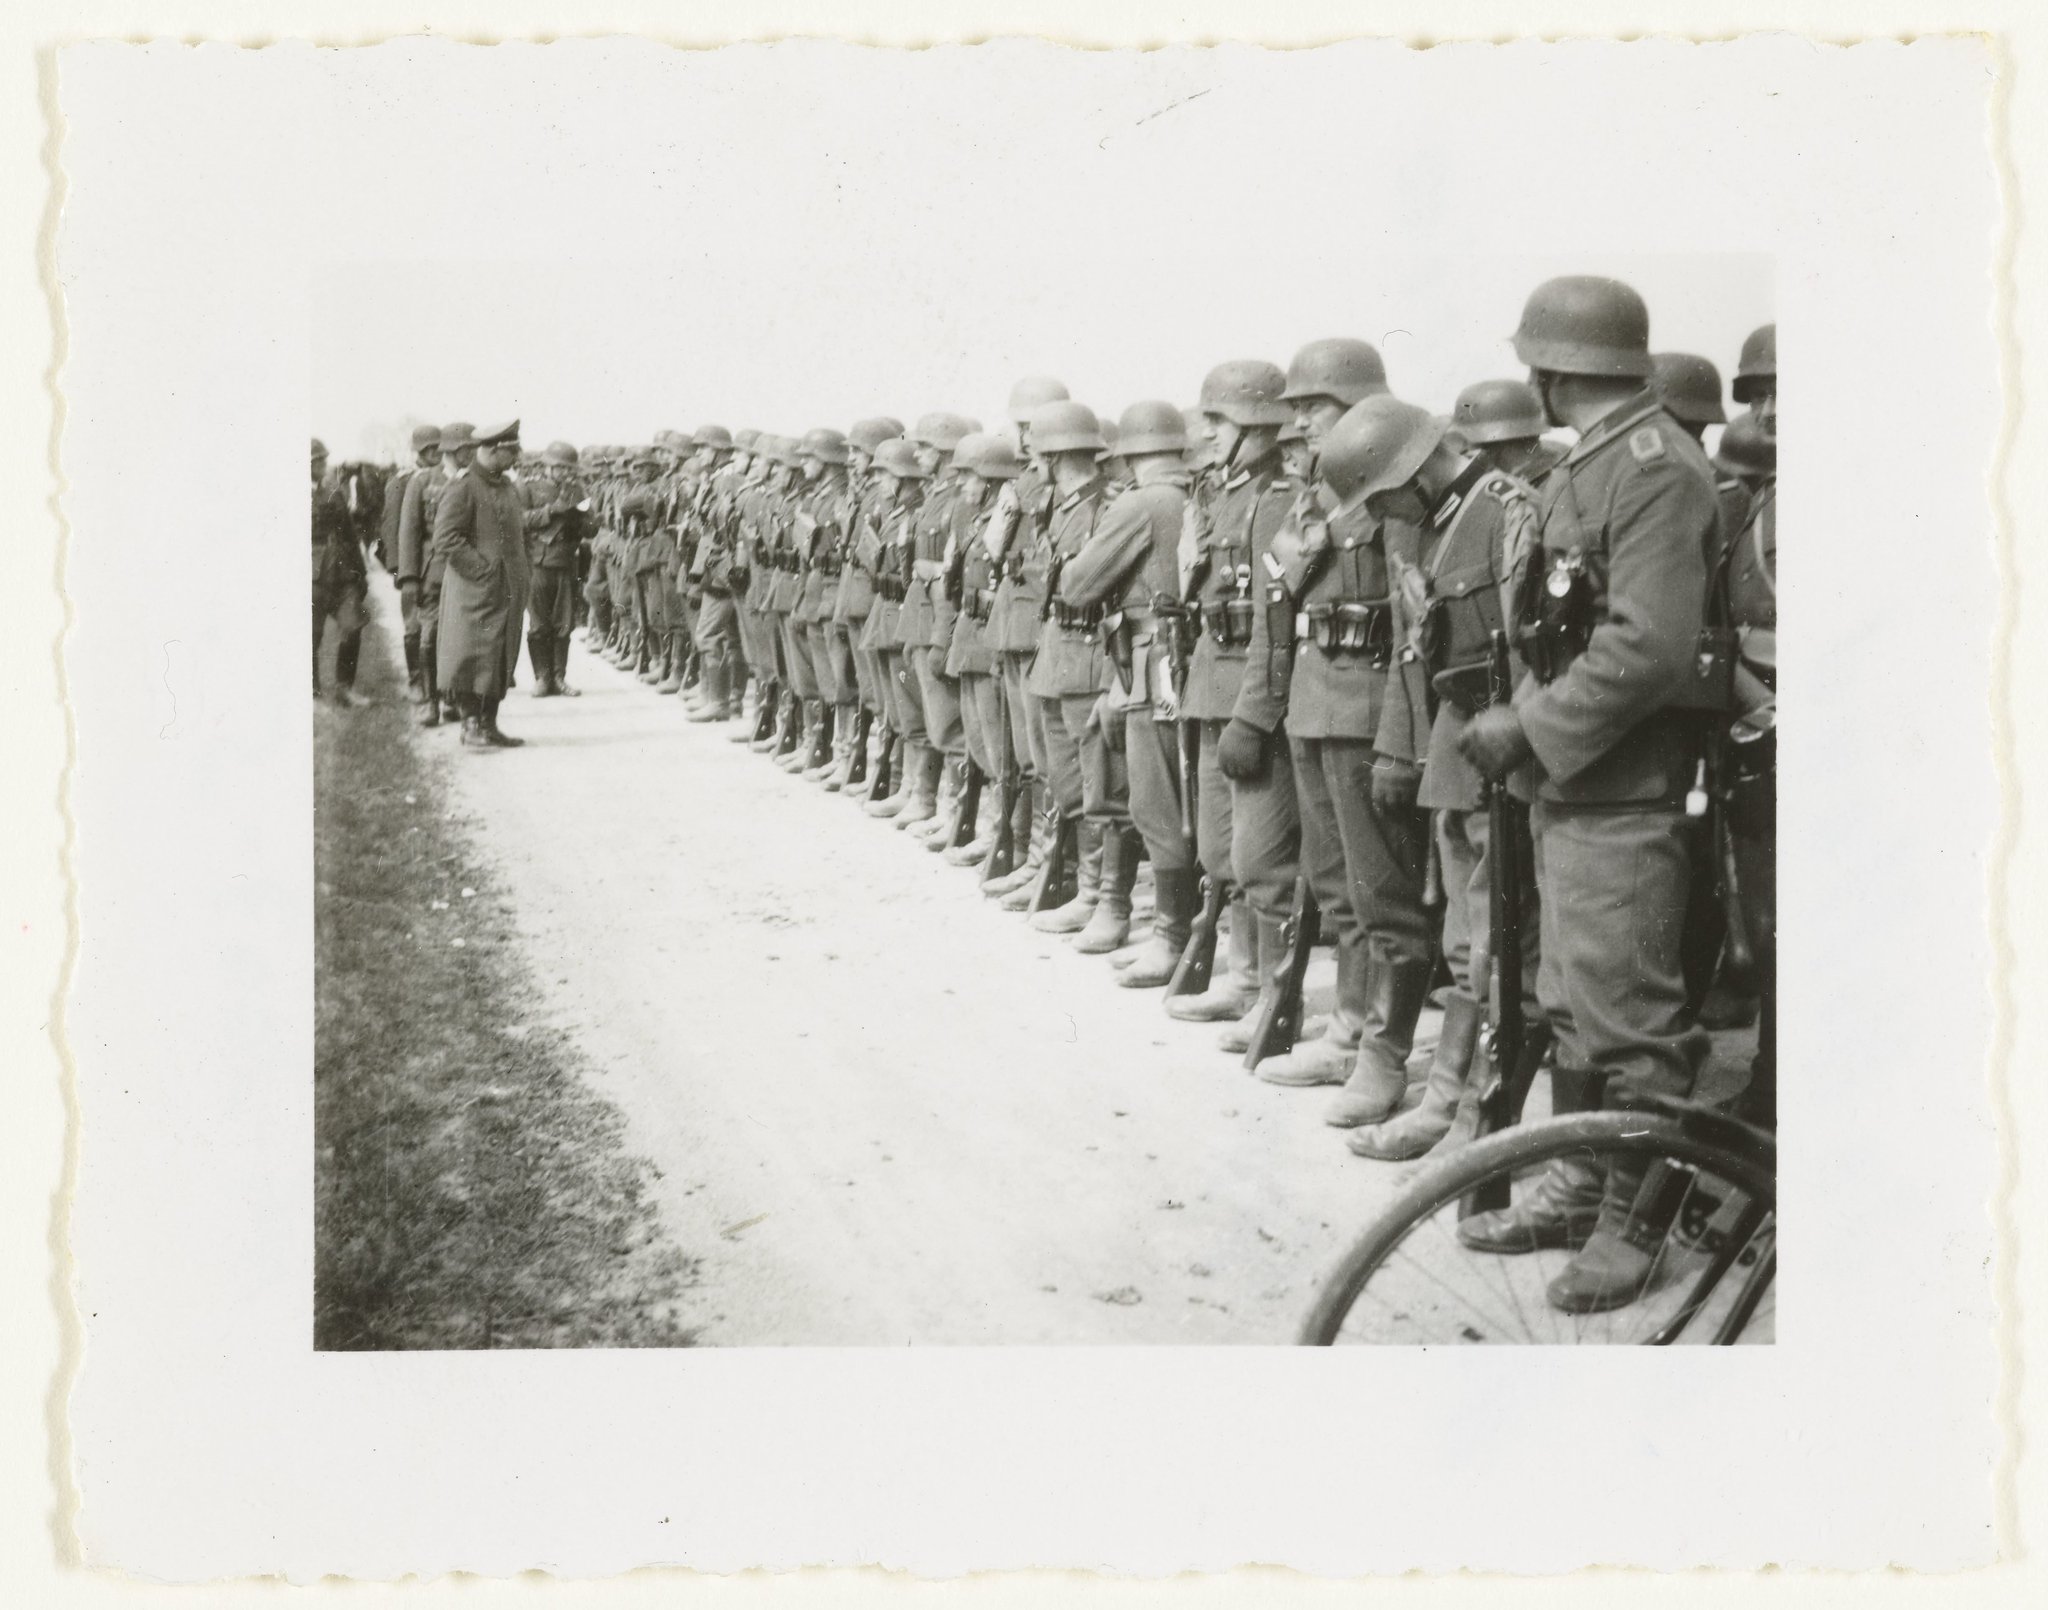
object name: photograph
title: Colonne Duitse soldaten op appel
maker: Anonymous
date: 1904-1941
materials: photographic support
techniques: gelatin silver print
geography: netherlands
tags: review, inspection (of company, unit, troop), occupation ~ war, netherlands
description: Een colonne Duitse soldaten op appel. Ze dragen allen een helm. Op de voorgrond een fietswiel. Achterop staat: In Holland. Am April 1941. Mayor von Wedelheim, Appell. Vermoedelijk dus een inspectie van majoor von Wedelheim van zijn troepen.